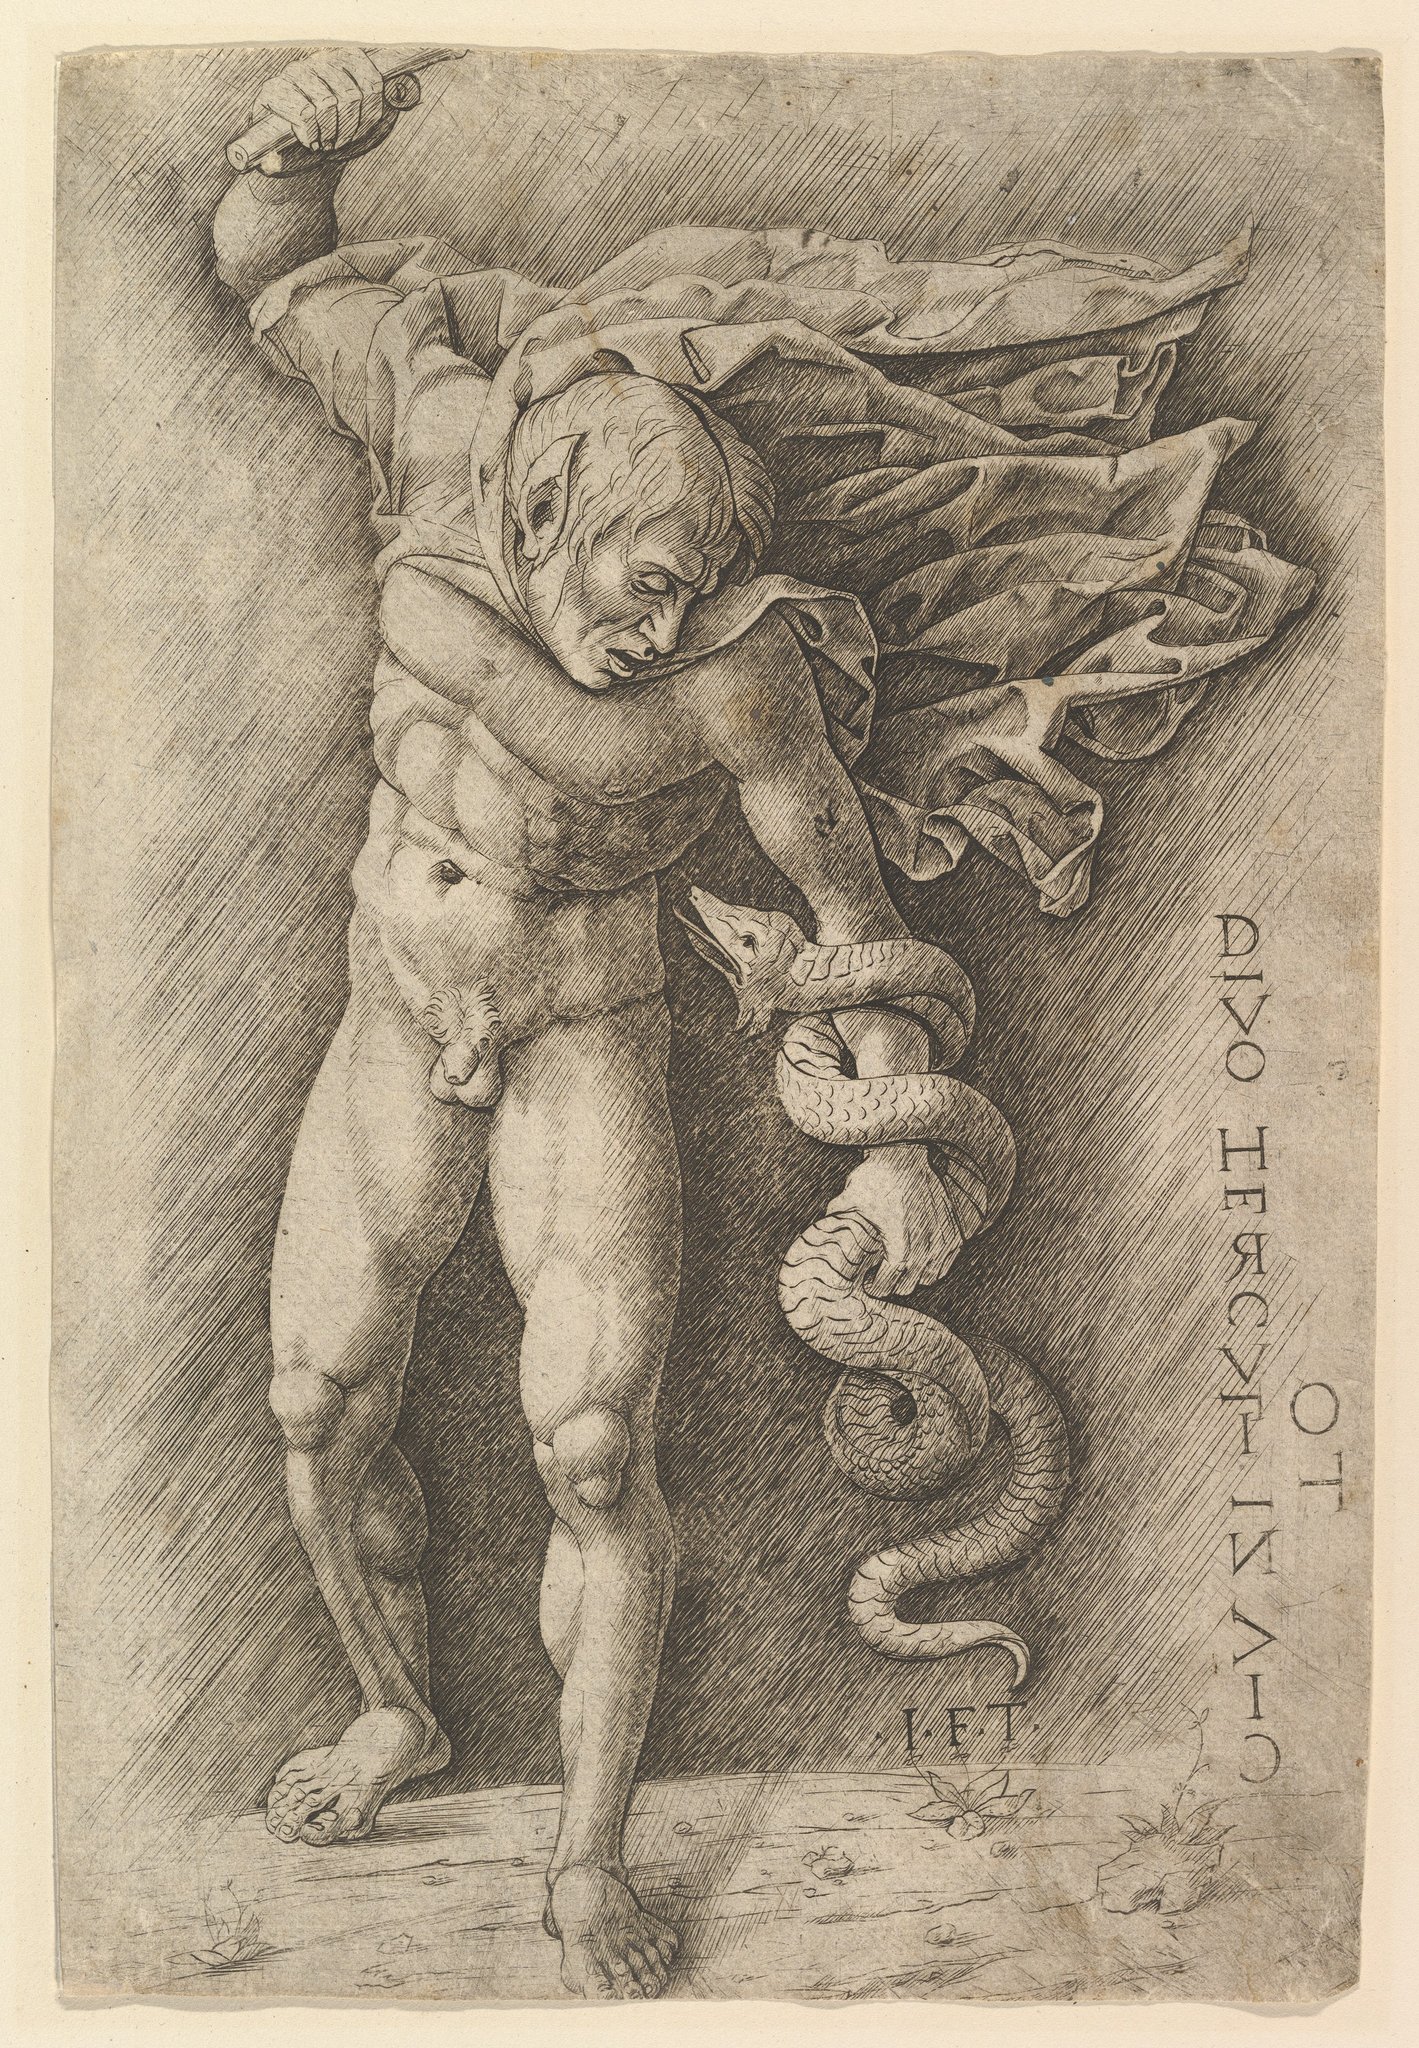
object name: print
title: Hercules and the Hydra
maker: andrea mantegna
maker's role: artist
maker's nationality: italian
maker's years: 1431-1506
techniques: engraving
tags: male nudes,hercules,mythical creatures,serpents